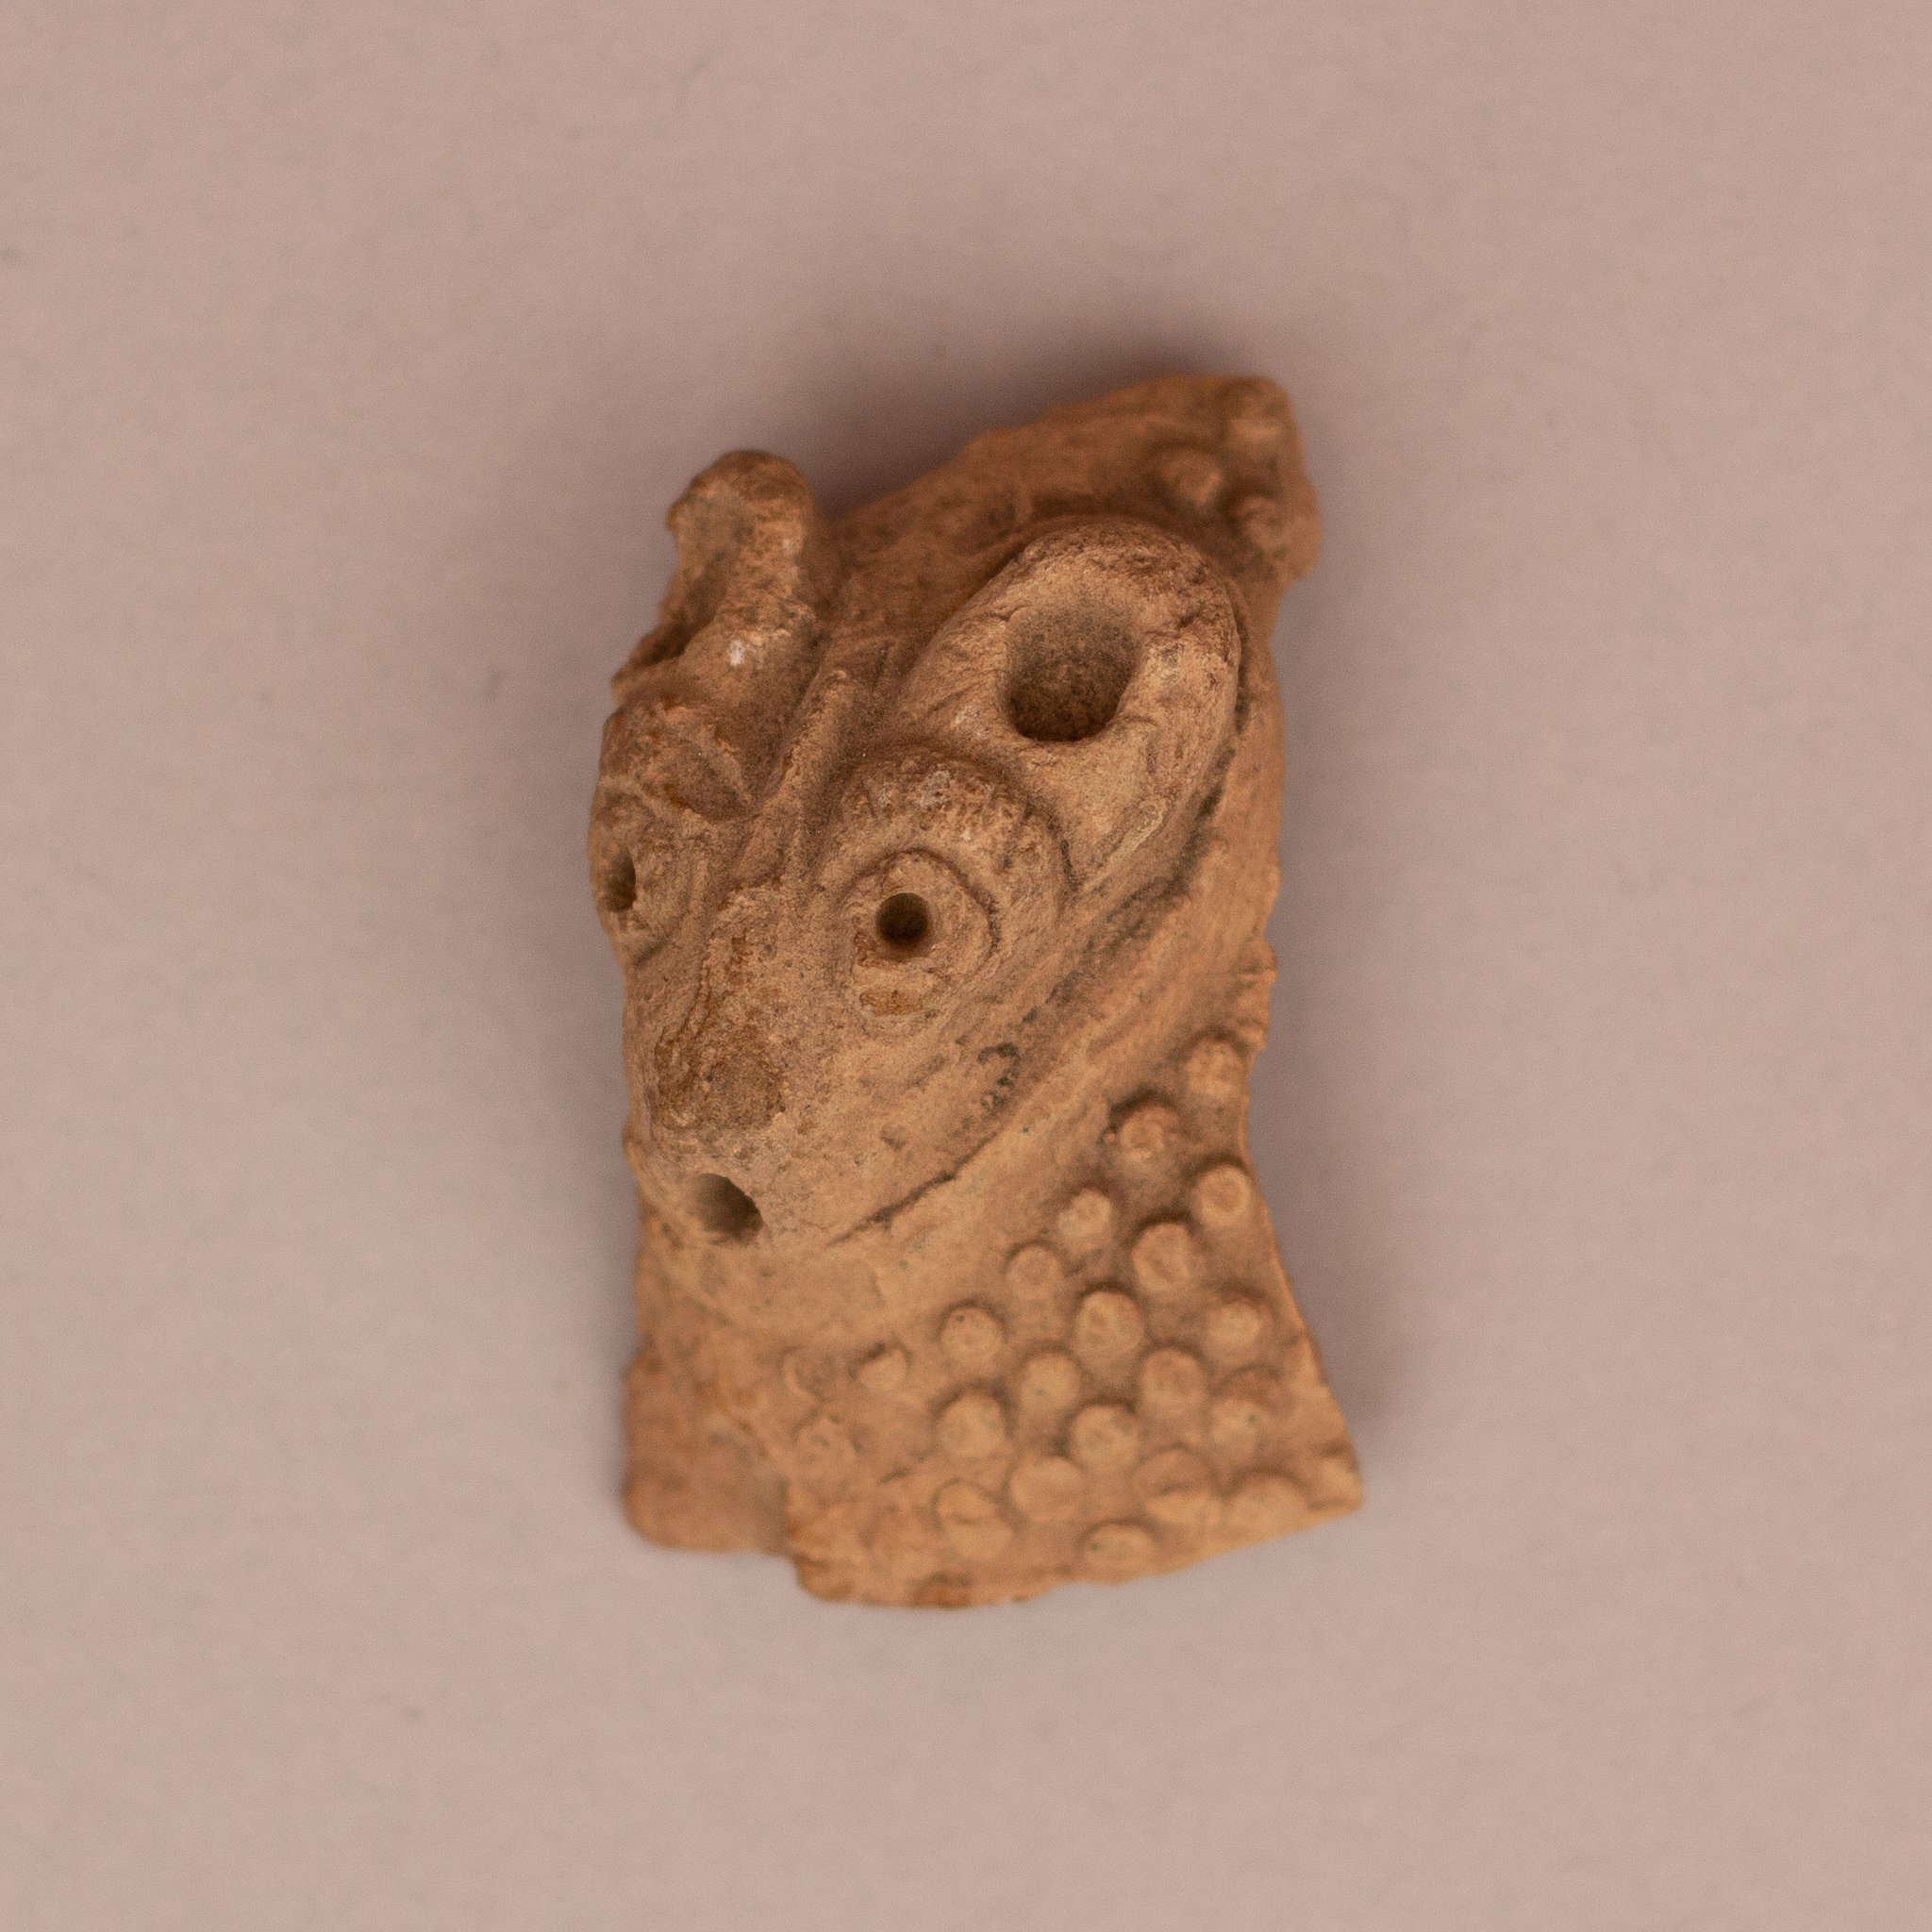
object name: sculpture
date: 1001-1200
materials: earthenware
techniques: molding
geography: iran